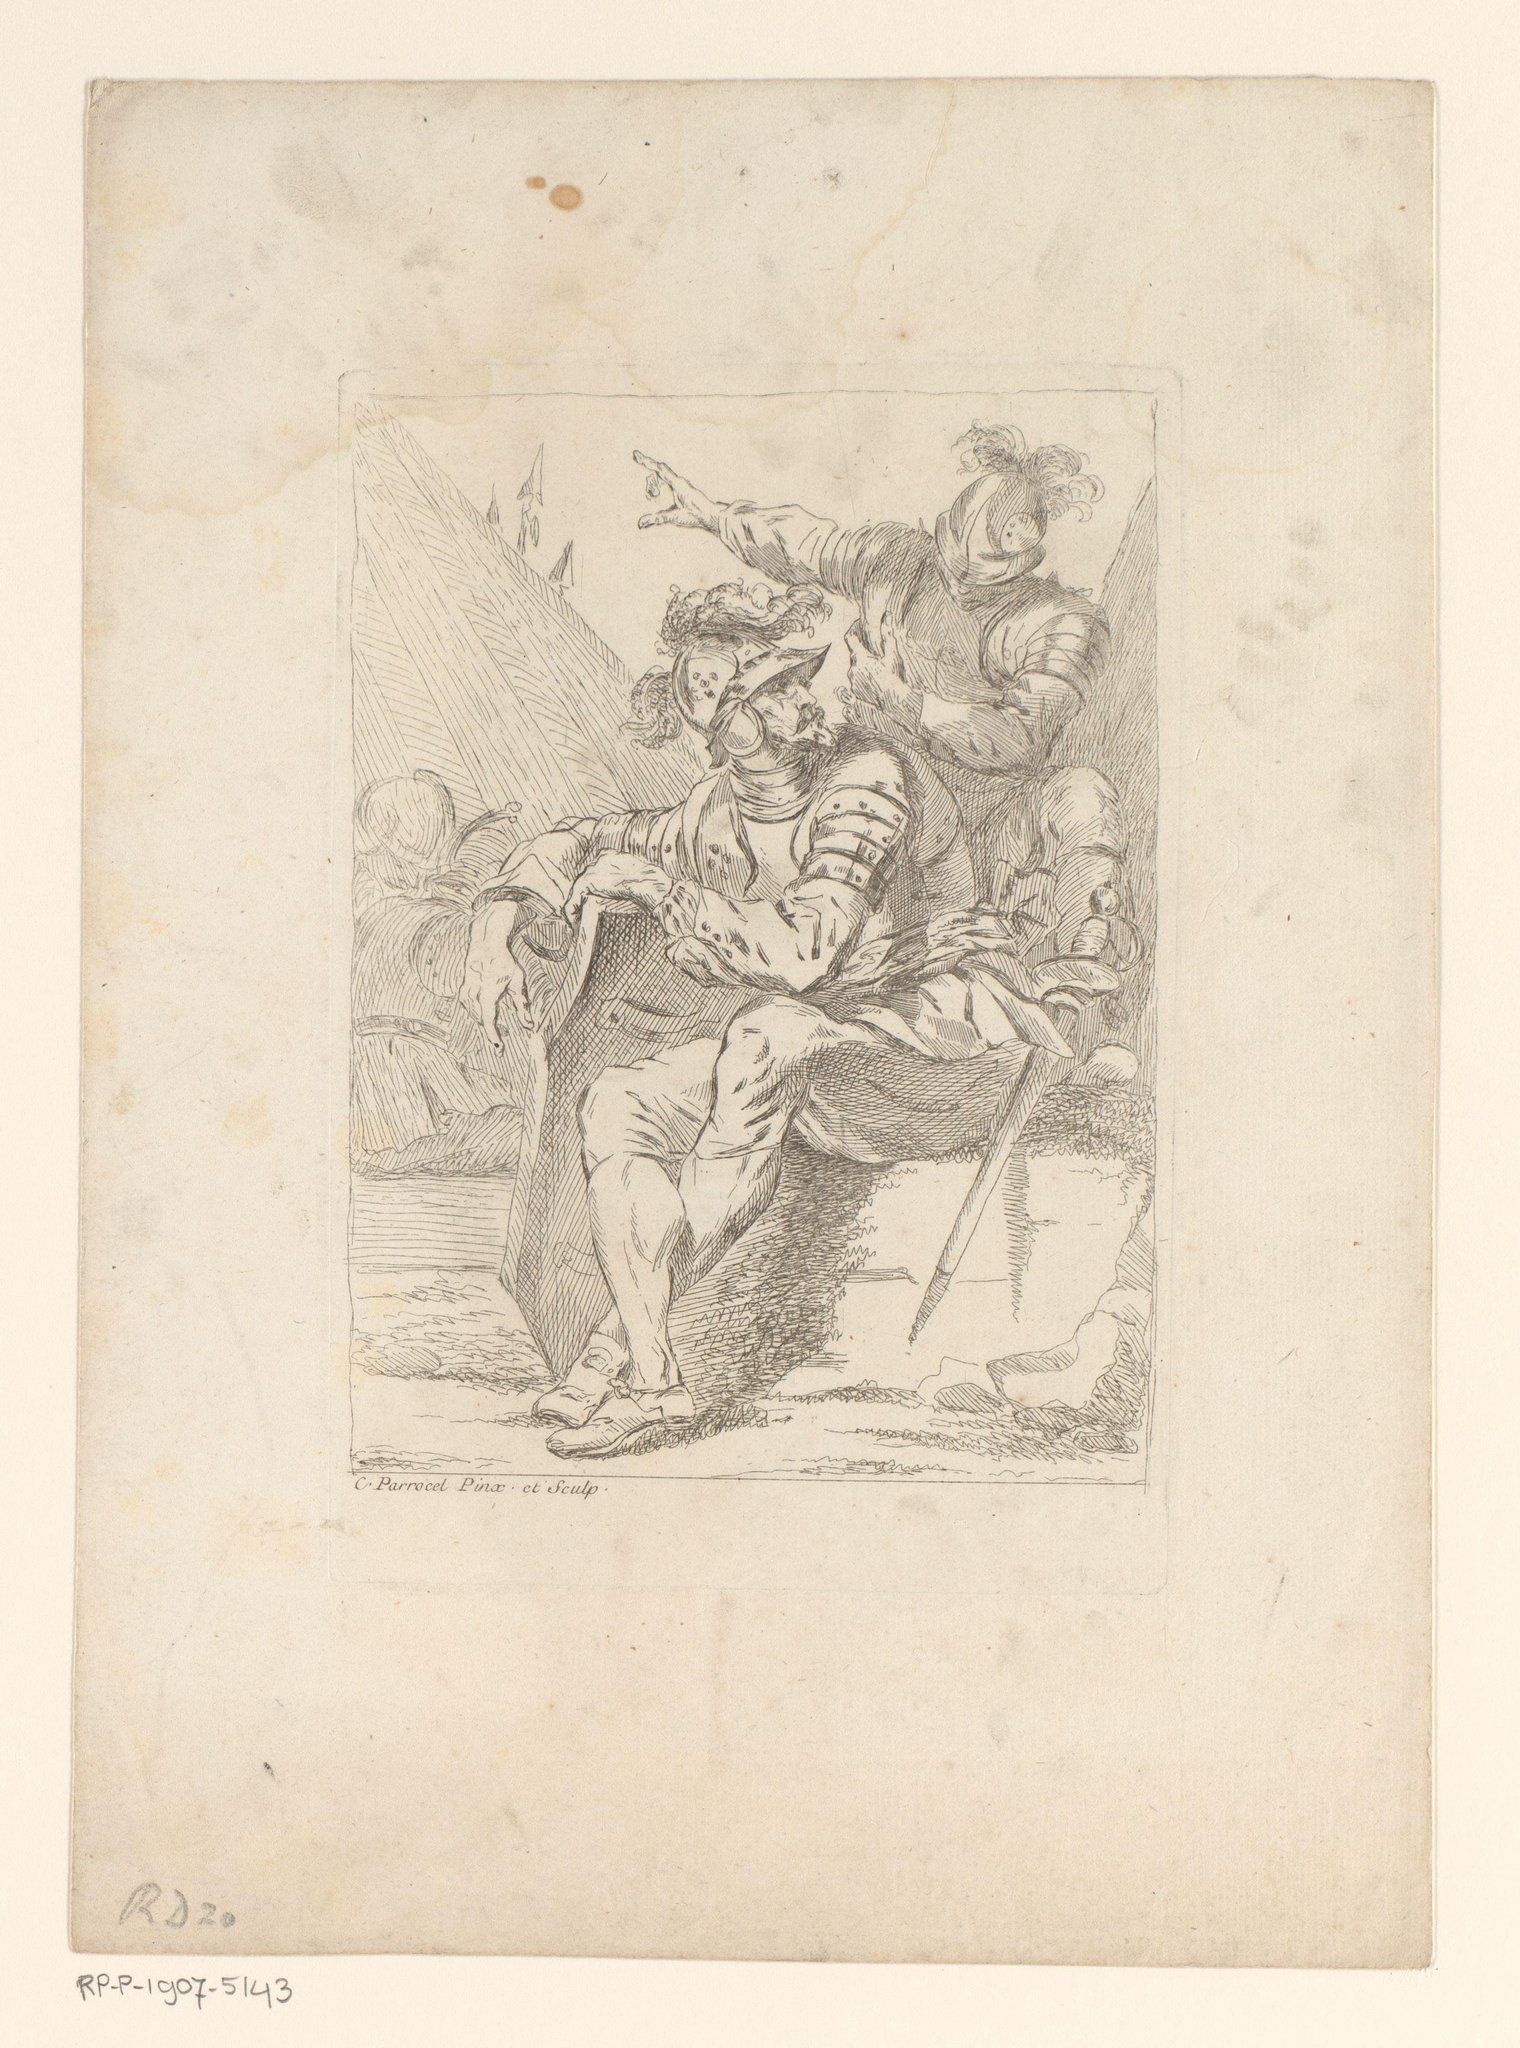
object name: print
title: Verschillende studies van soldaten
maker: charles parrocel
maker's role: draughtsman, painter, print maker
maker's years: 1688-1752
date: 1698-1752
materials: paper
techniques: etching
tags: the soldier; the soldier's life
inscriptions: collector's mark: Lugt 2228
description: Prent maakt deel uit van een ongenummerde serie van zes prenten.